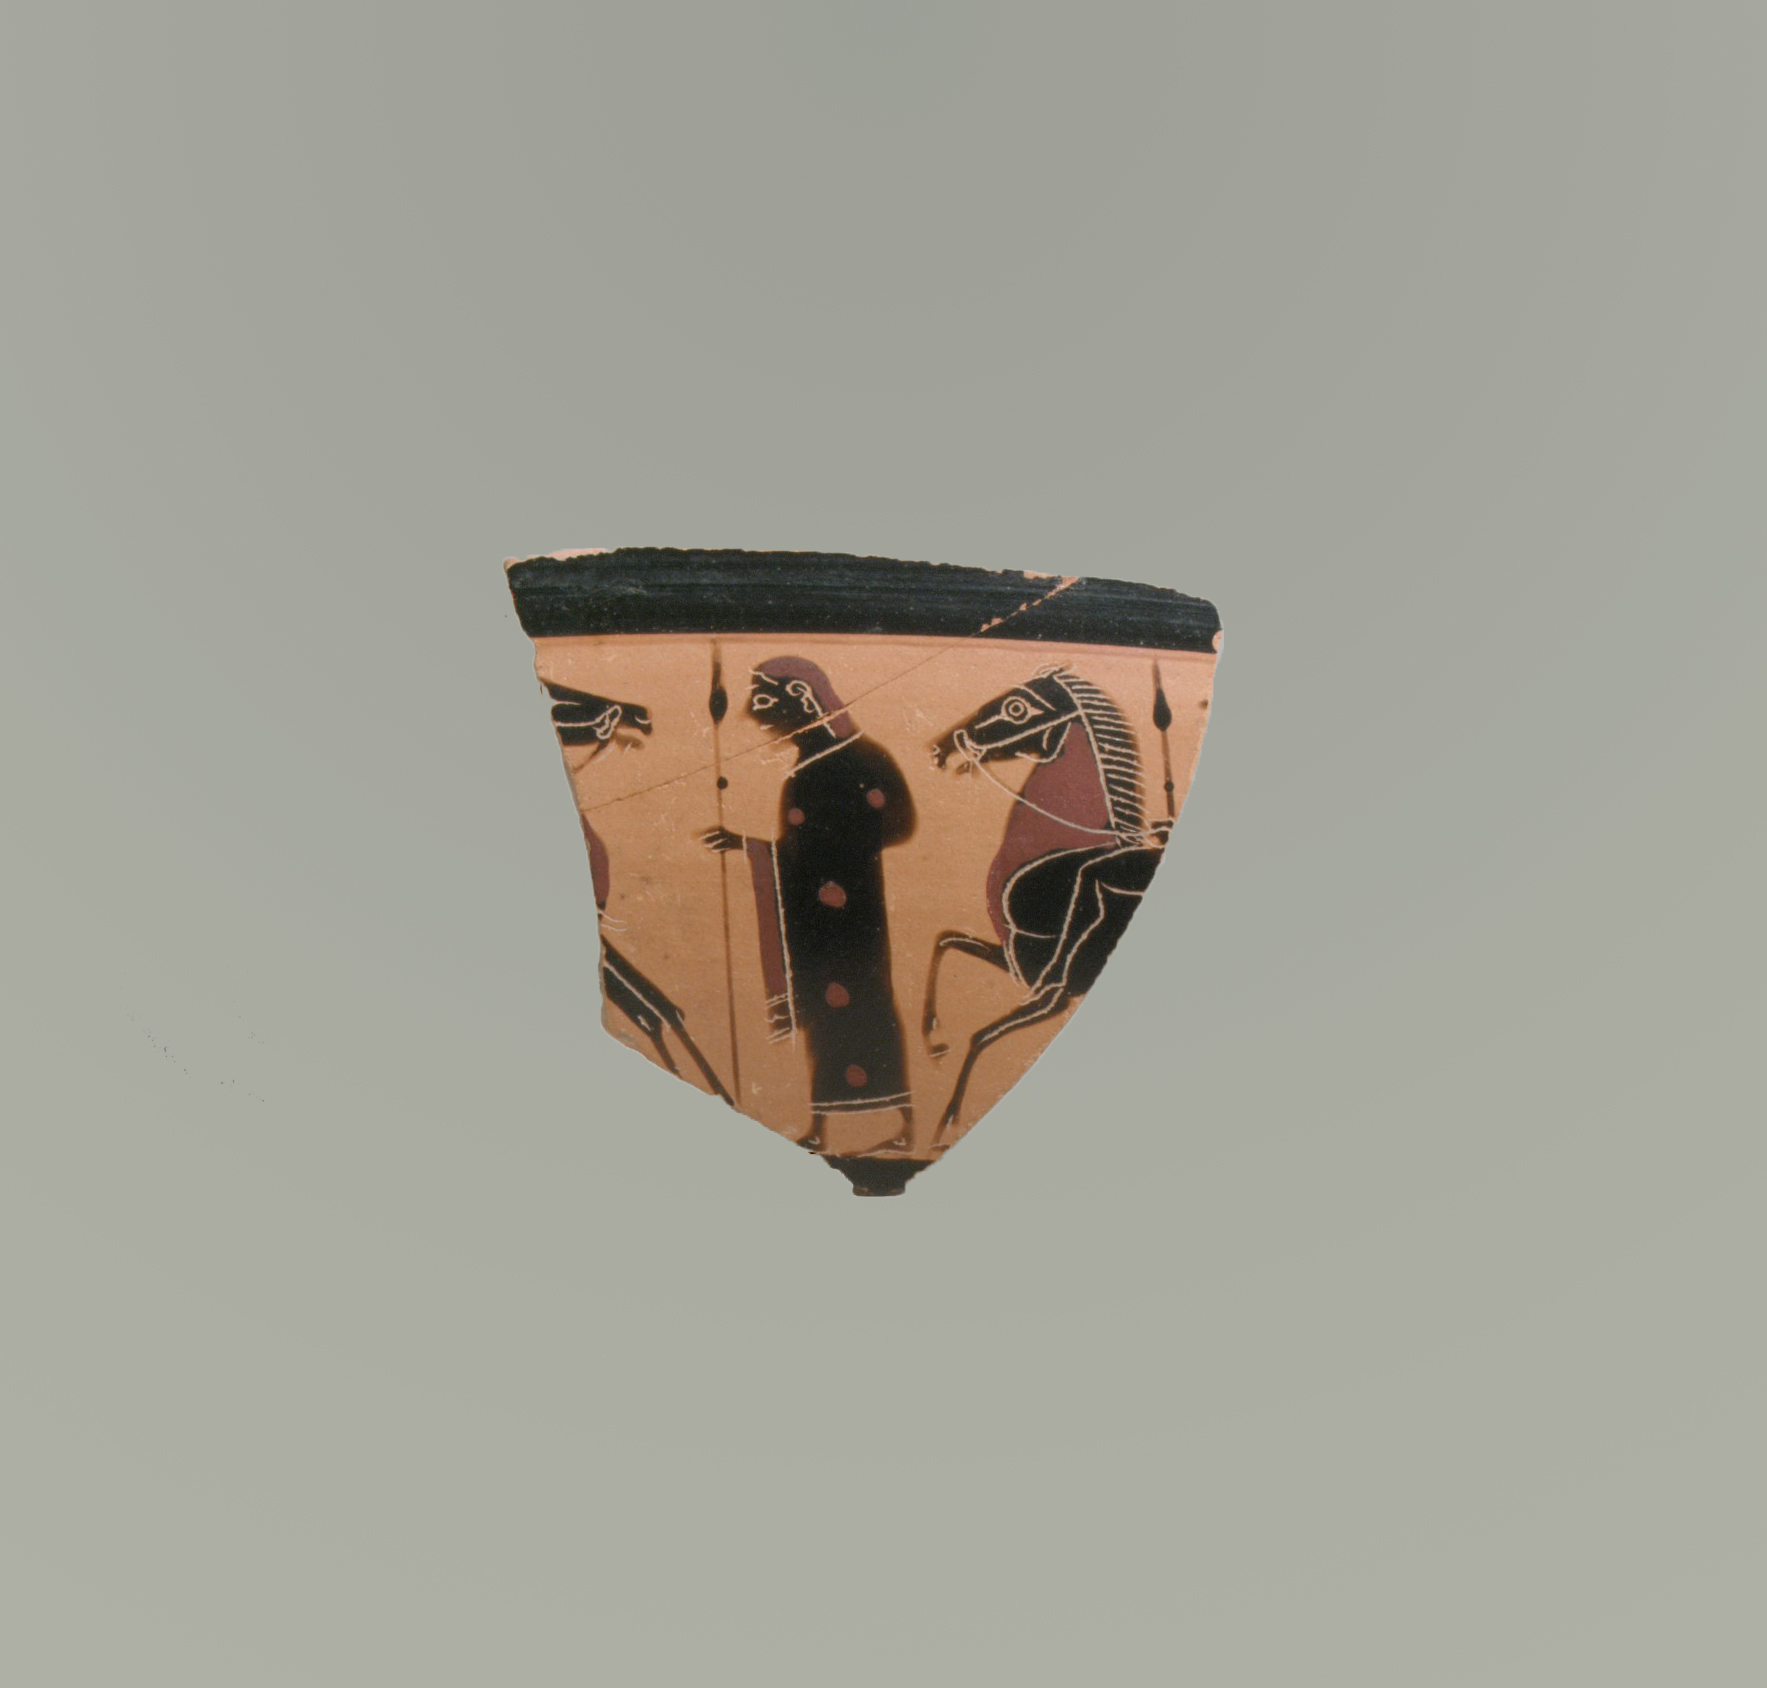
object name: kylix, band cup fragment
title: Fragment of a terracotta kylix: band-cup (drinking cup)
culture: greek, attic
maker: amasis painter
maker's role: artist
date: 550-540 BCE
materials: terracotta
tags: men,horses